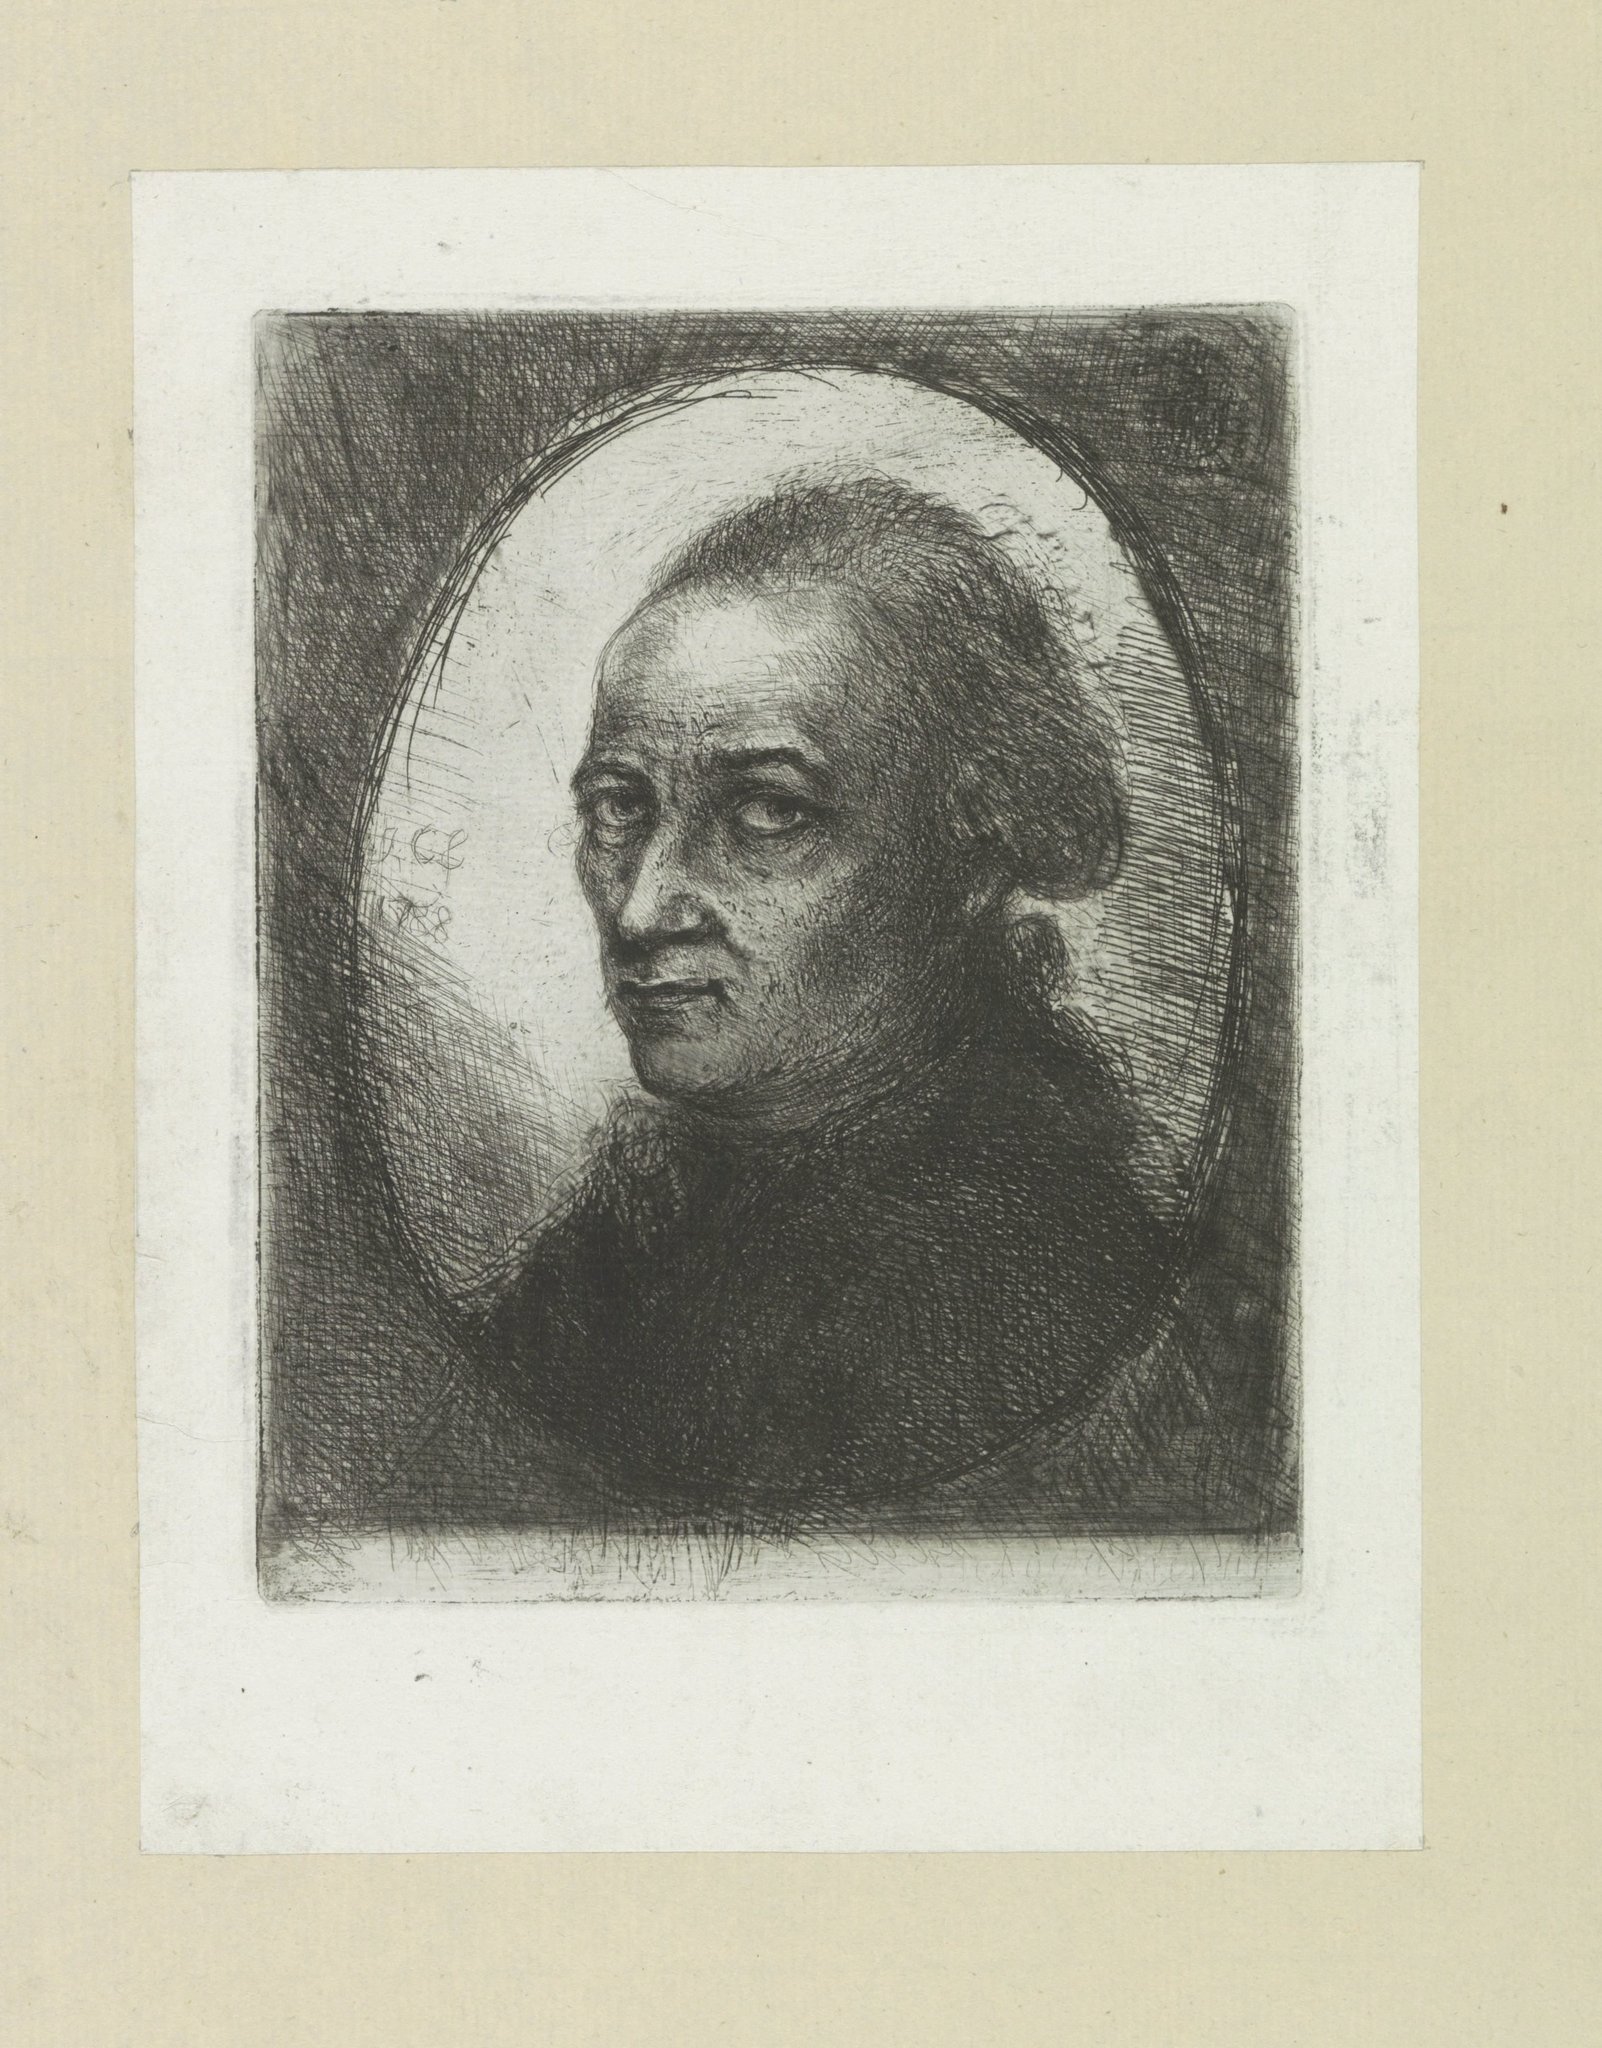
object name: album leaf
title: The Compleat Work of Etchings by John Chalon / Oeuvre Complette des Eaux Fortes par Jean Chalon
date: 1788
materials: paper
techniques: drypoint, etching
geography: london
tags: print maker, jan chalon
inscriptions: collector's mark: ‘RIJKS / MUSM’, collector's mark: ‘B’